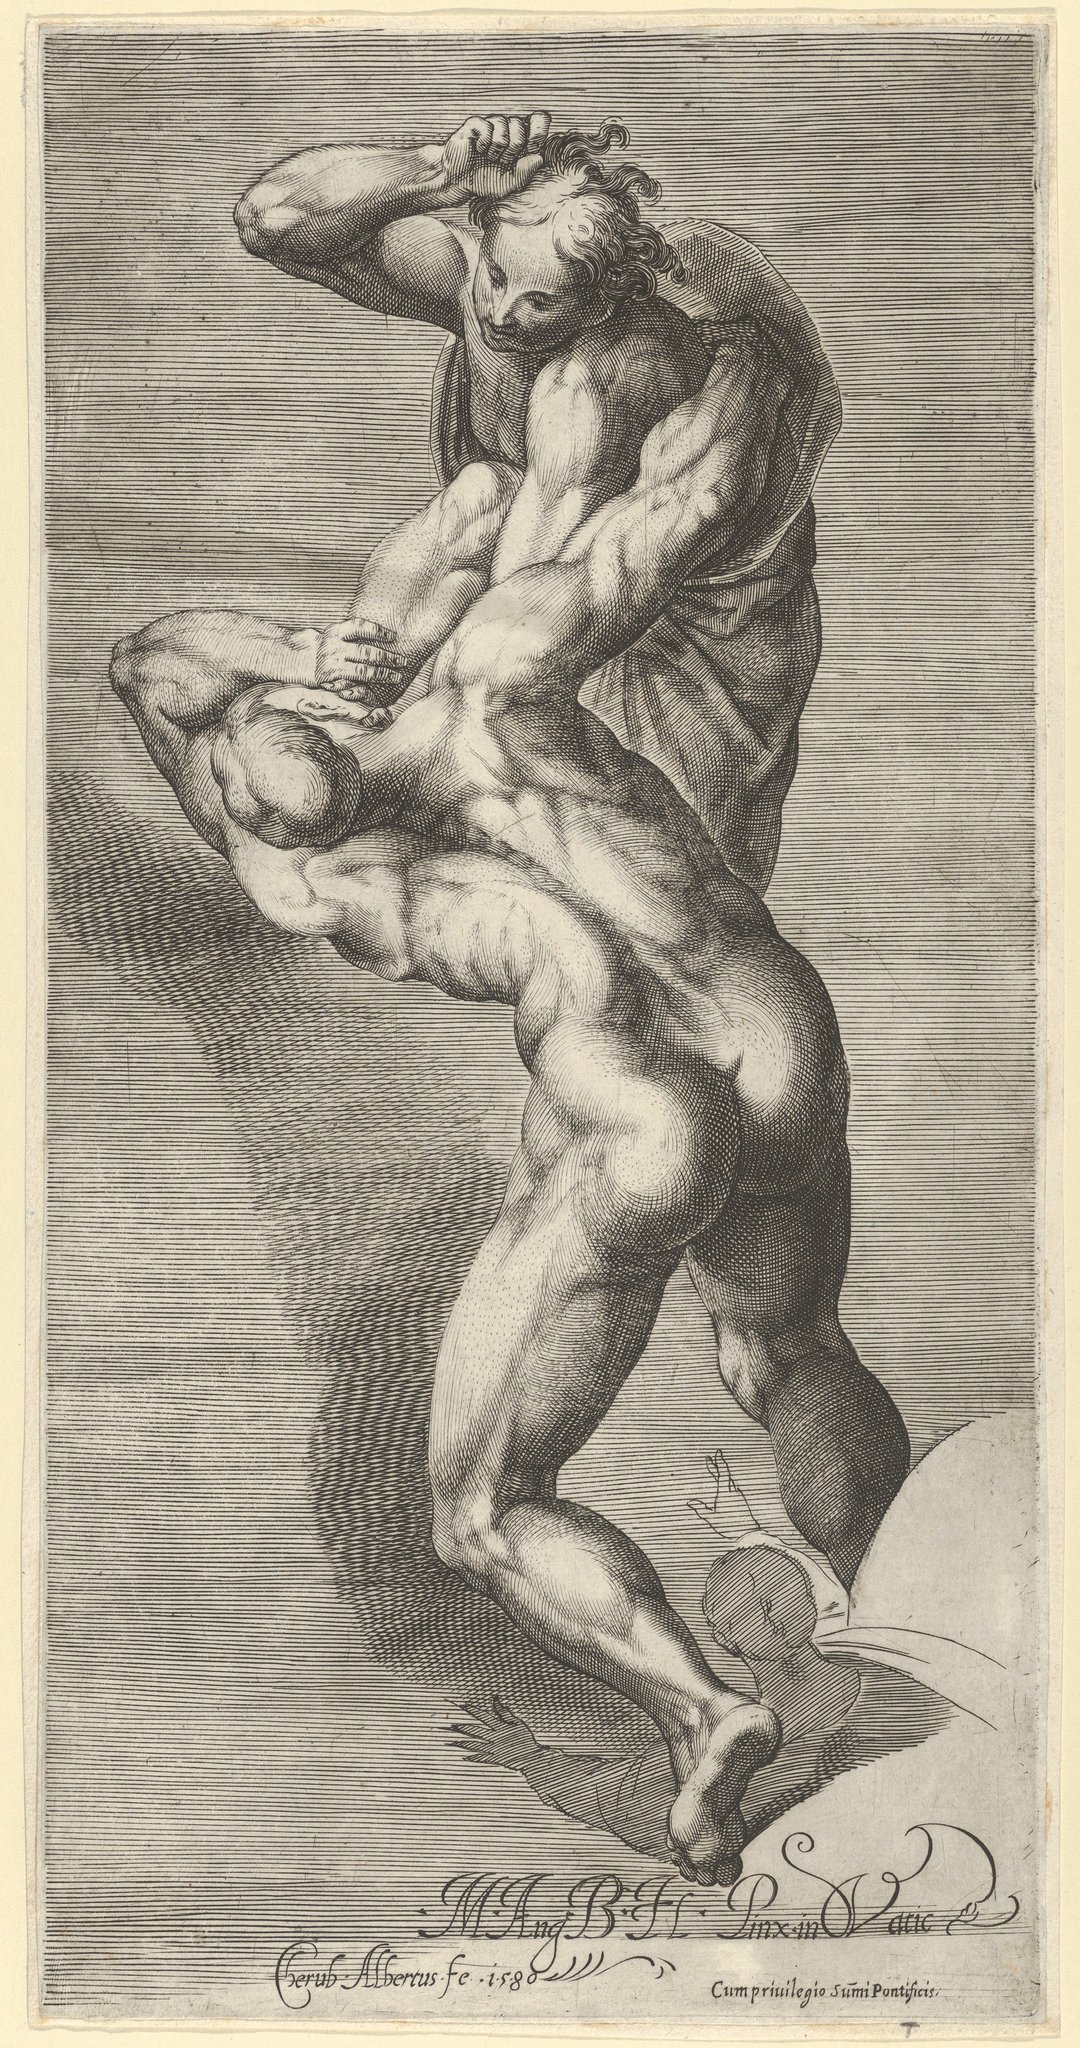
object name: print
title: Two damned souls fighting, after Michelangelo's 'The Last Judgment' fresco in the Sistine Chapel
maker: cherubino alberti (zaccaria mattia)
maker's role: artist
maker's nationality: italian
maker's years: 1553-1615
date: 1580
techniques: engraving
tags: male nudes,last judgement